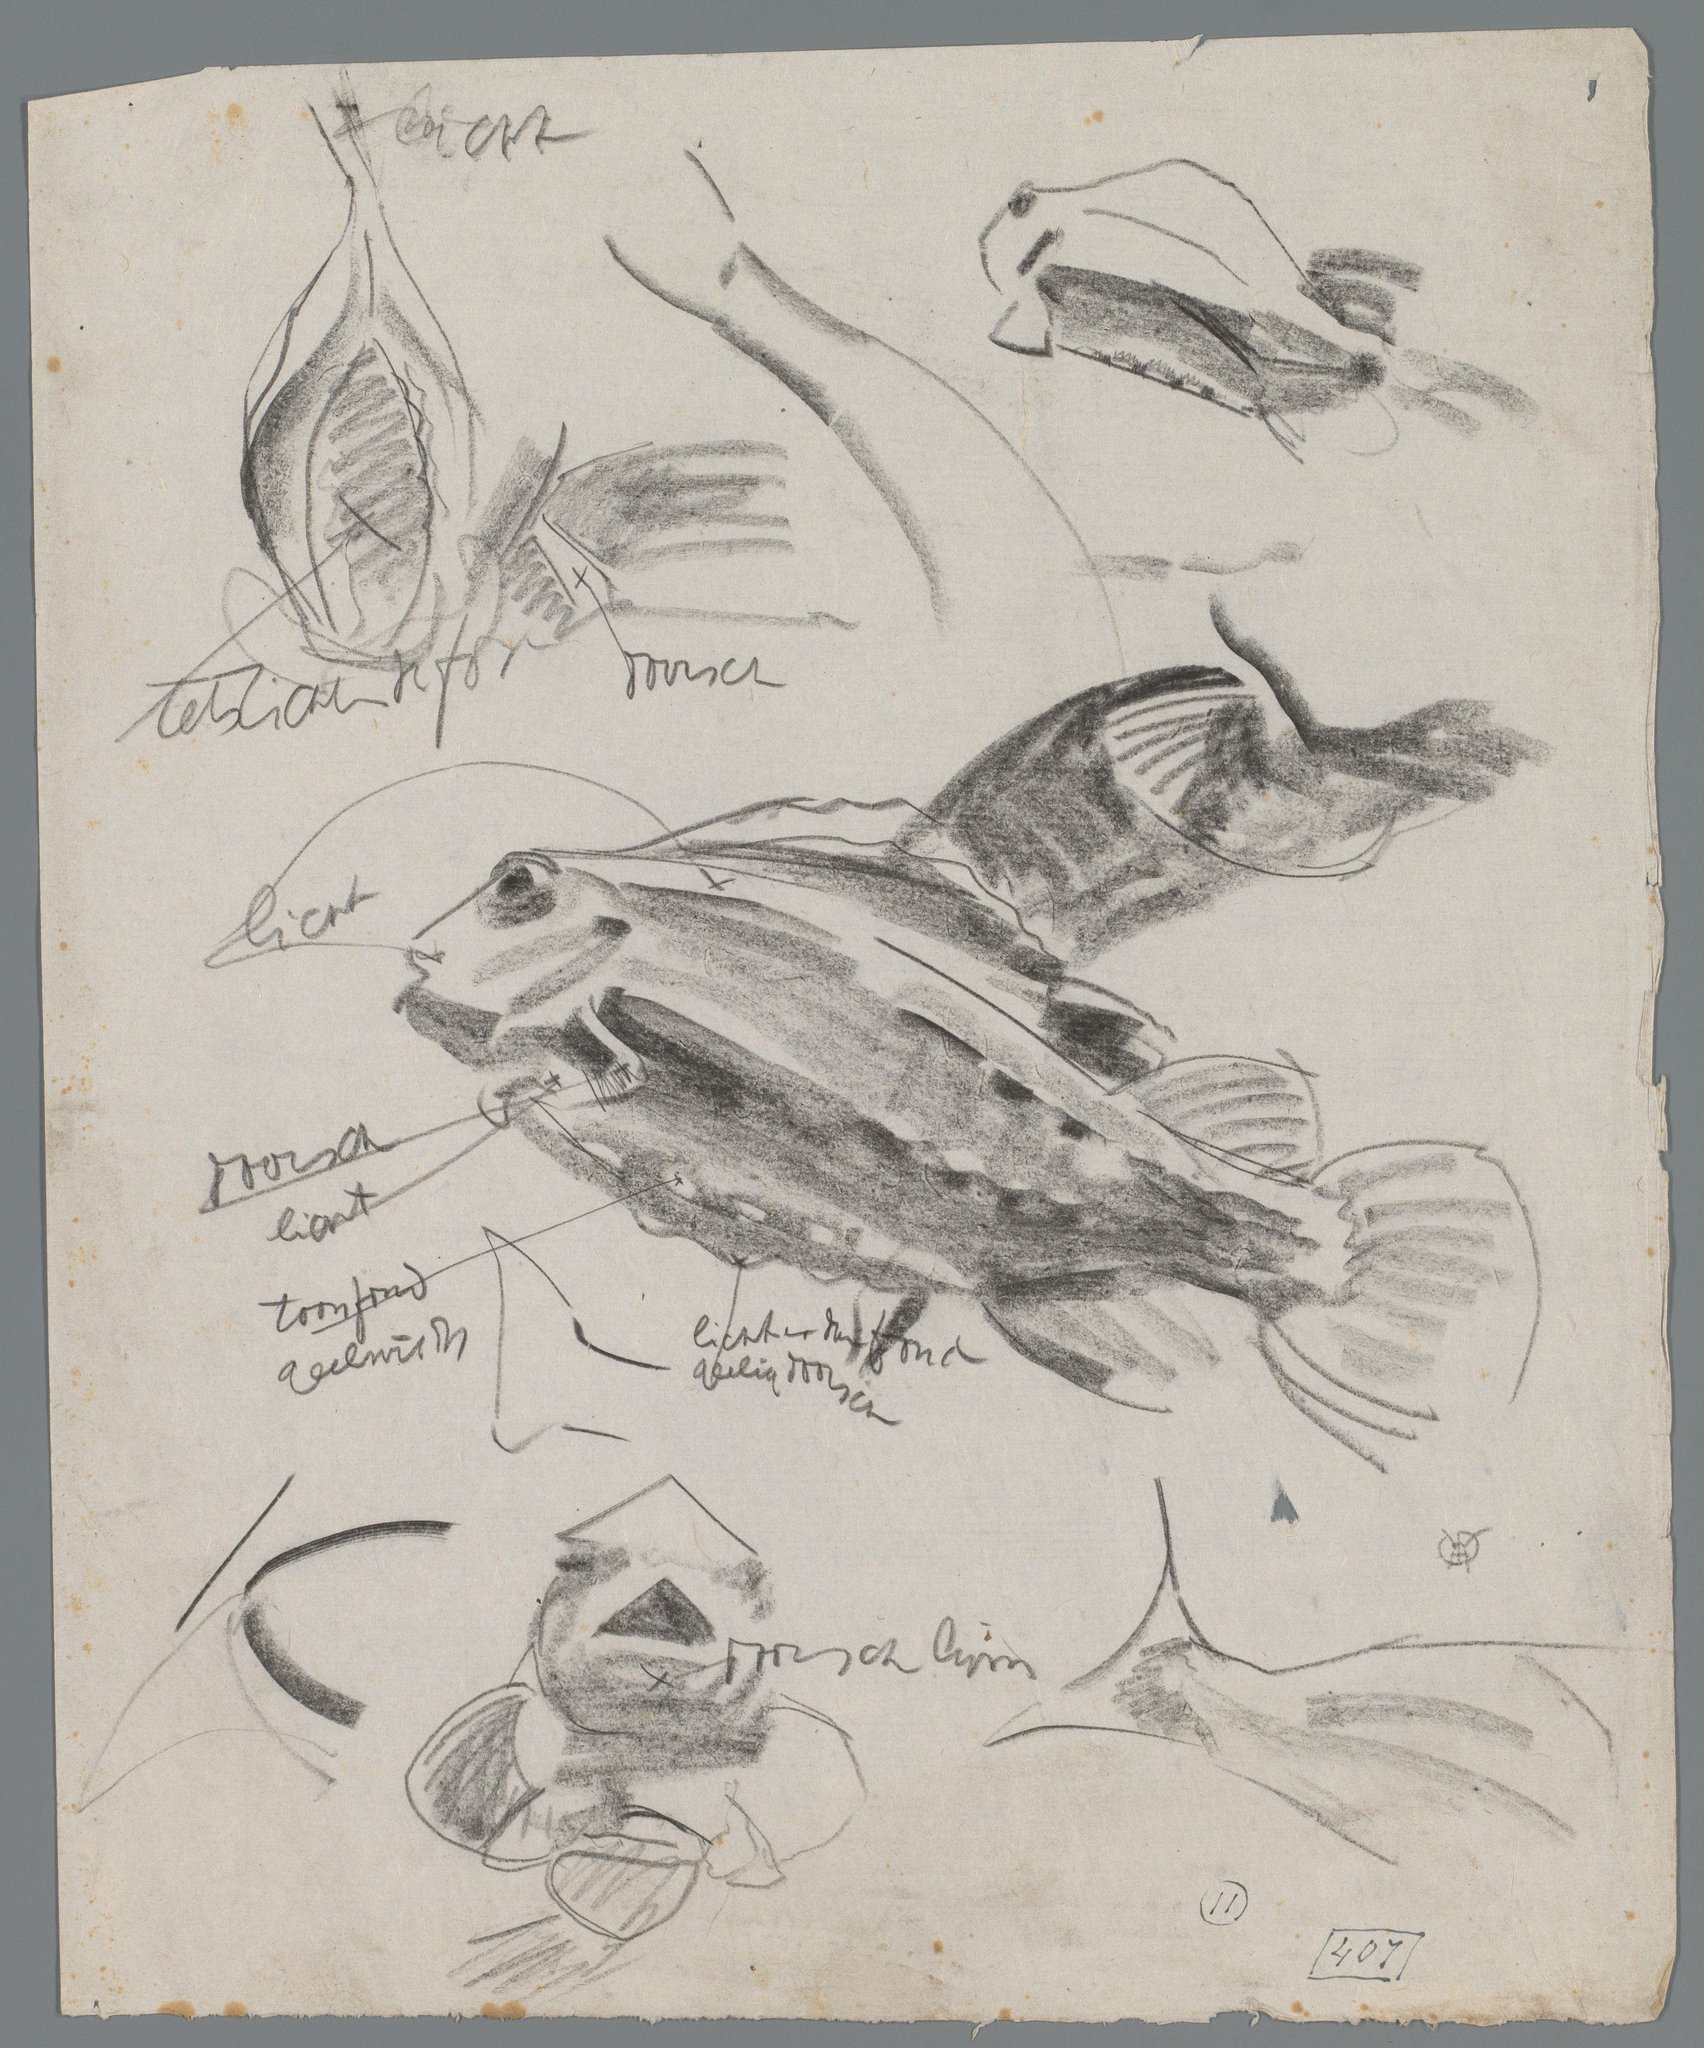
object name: drawing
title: Studies van een vis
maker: gerrit willem dijsselhof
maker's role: designer, draughtsman, print maker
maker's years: 1866-1924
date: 1876-1924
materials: chalk, paper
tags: fishes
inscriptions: number: ‘11’, number: ‘407’